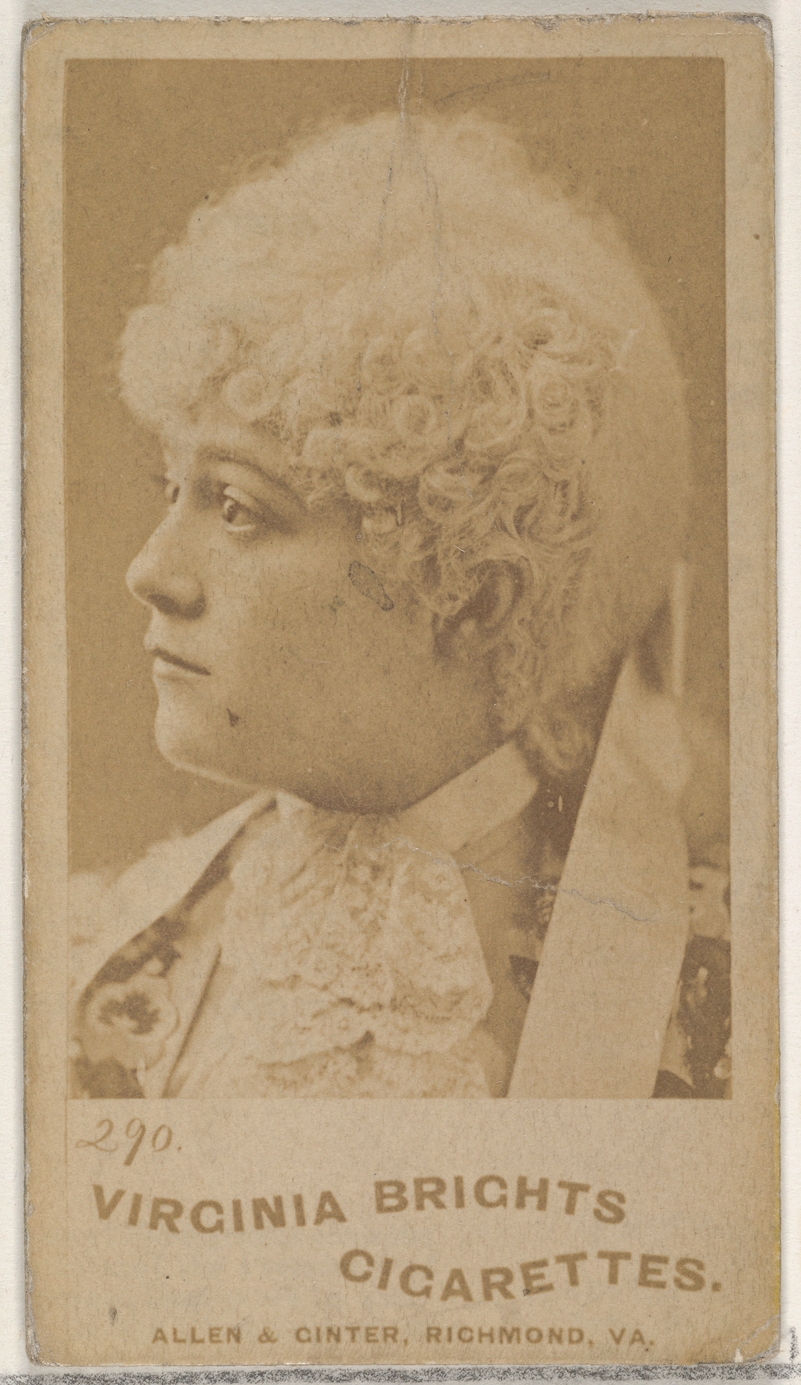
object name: photograph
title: Card 290, from the Actors and Actresses series (N45, Type 4) for Virginia Brights Cigarettes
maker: allen & ginter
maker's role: publisher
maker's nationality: american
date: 1888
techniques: albumen silver print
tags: women,actresses